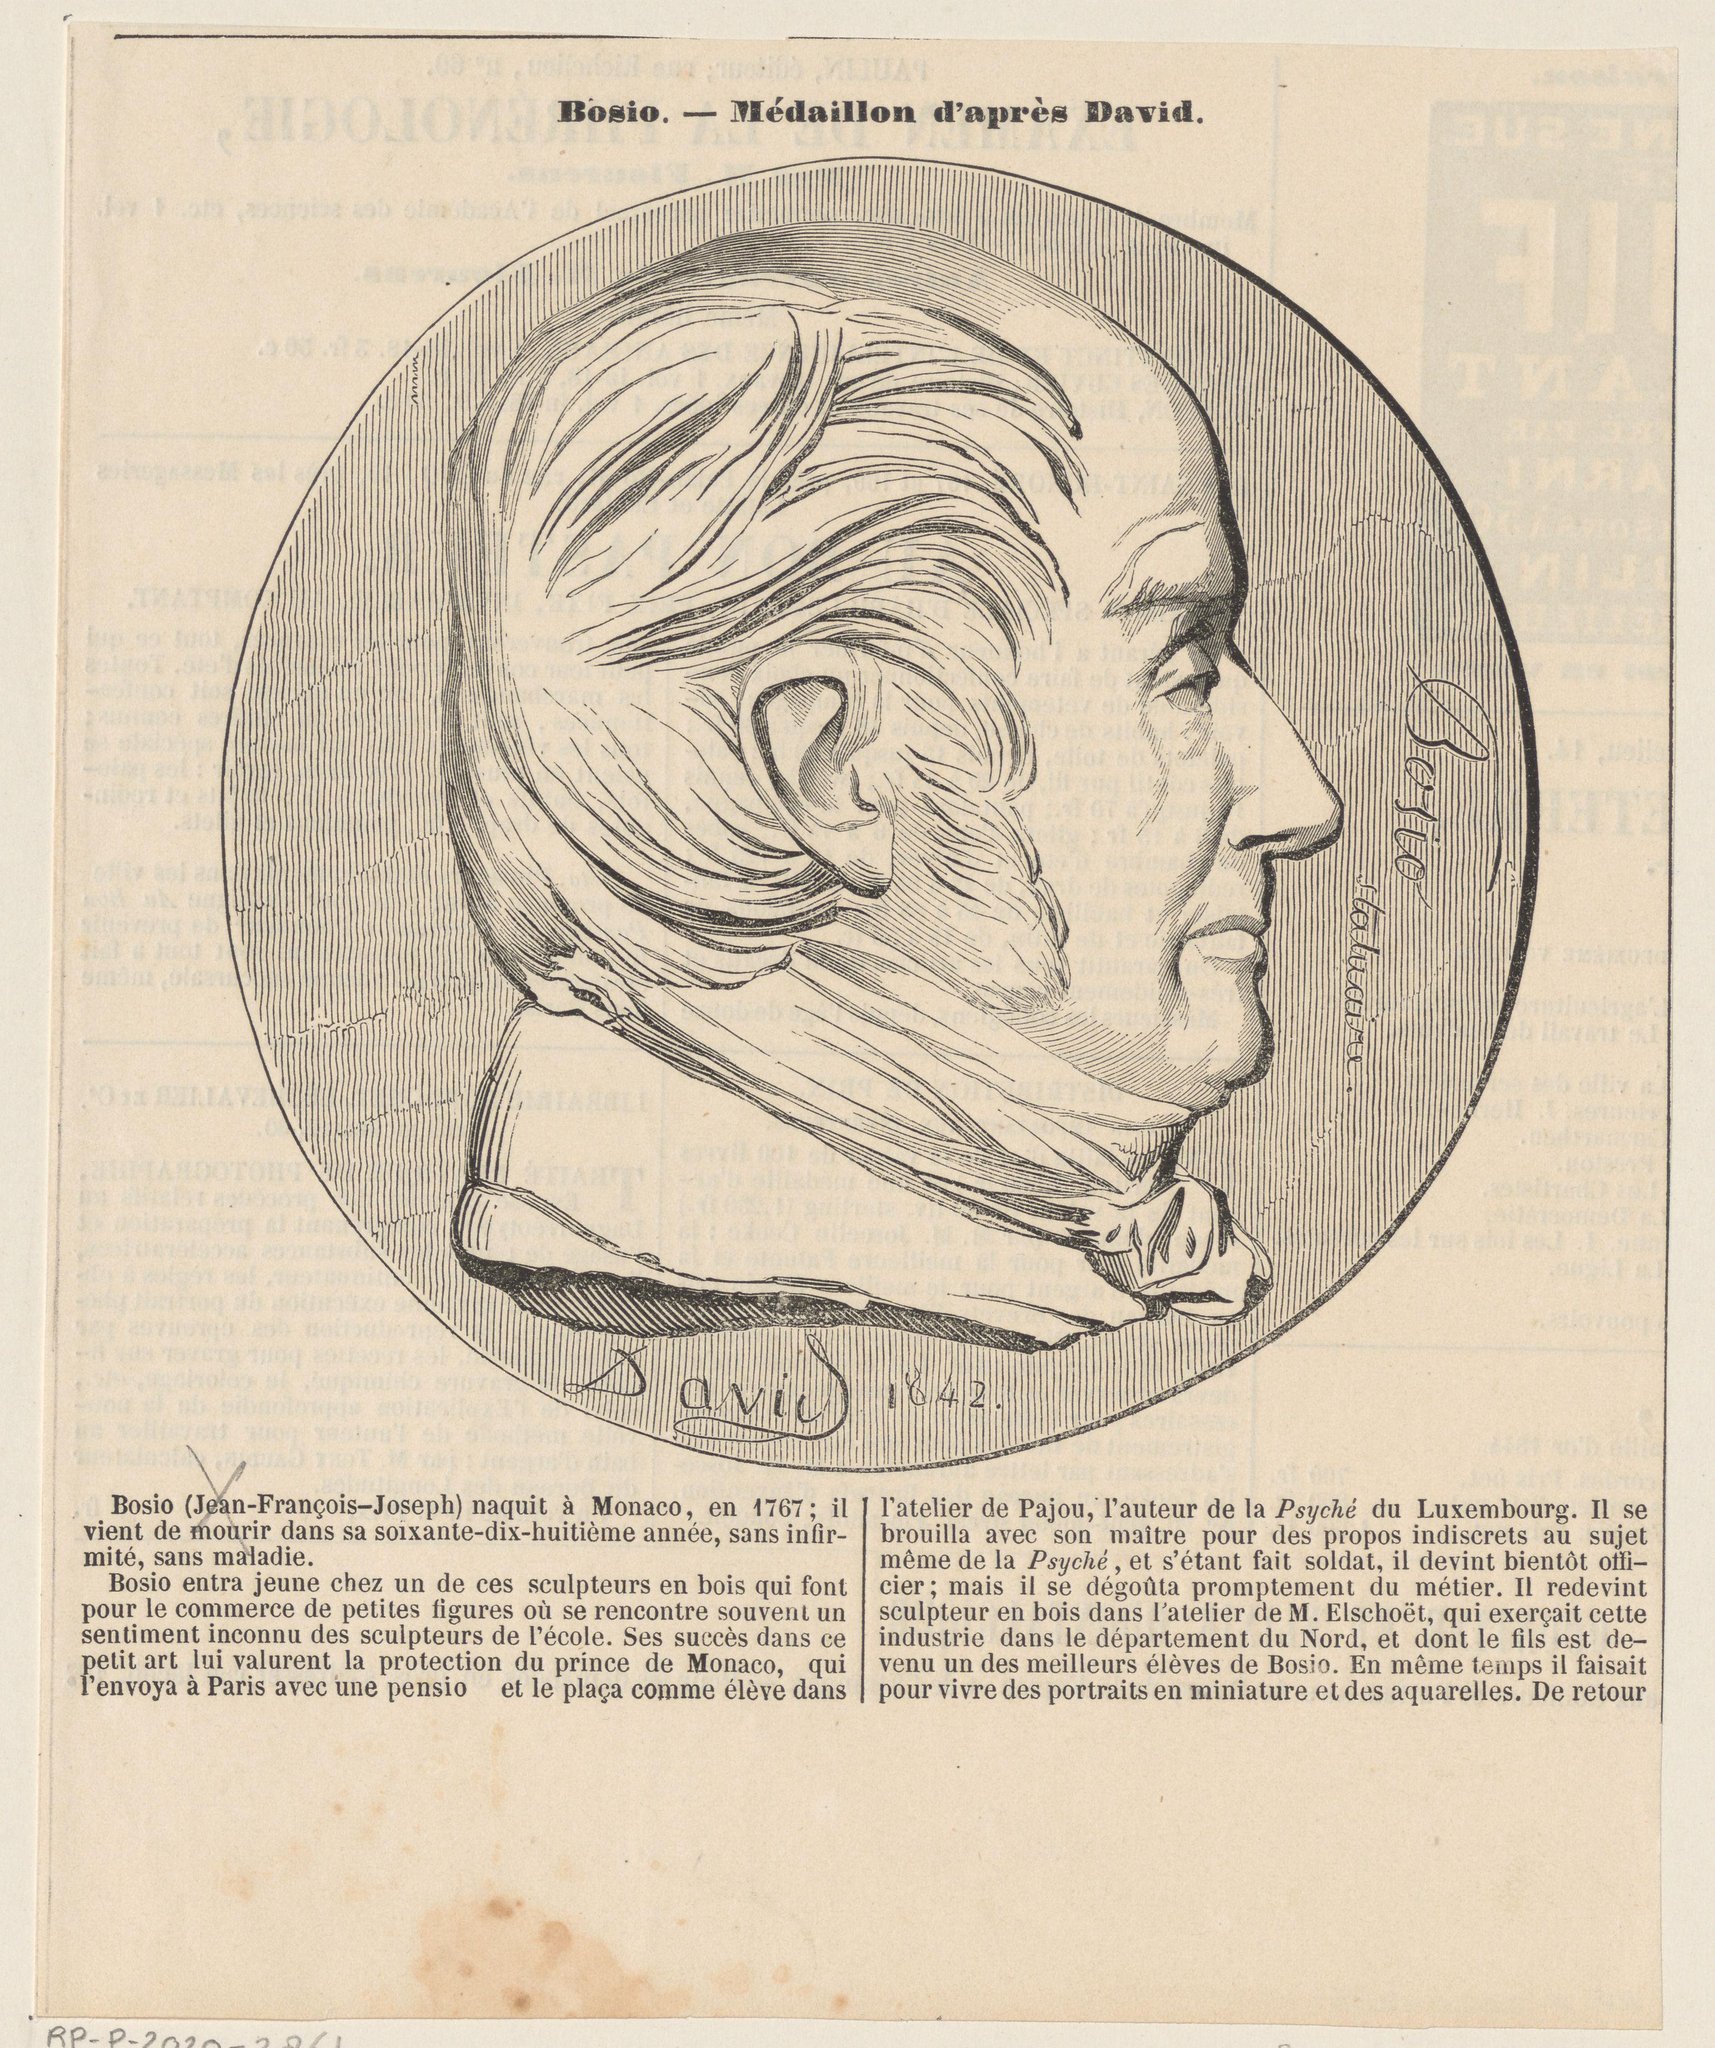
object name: print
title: Portret van Jean-François Bosio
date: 1845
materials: paper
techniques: letterpress printing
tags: paris, draughtsman, jean françois bosio, historical persons, medal (considered as a piece of sculpture, regardless of its specific function), portrait, self-portrait of artist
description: Prent uit: L'Illustration, journal universel, nr. 128, 9 augustus 1845.